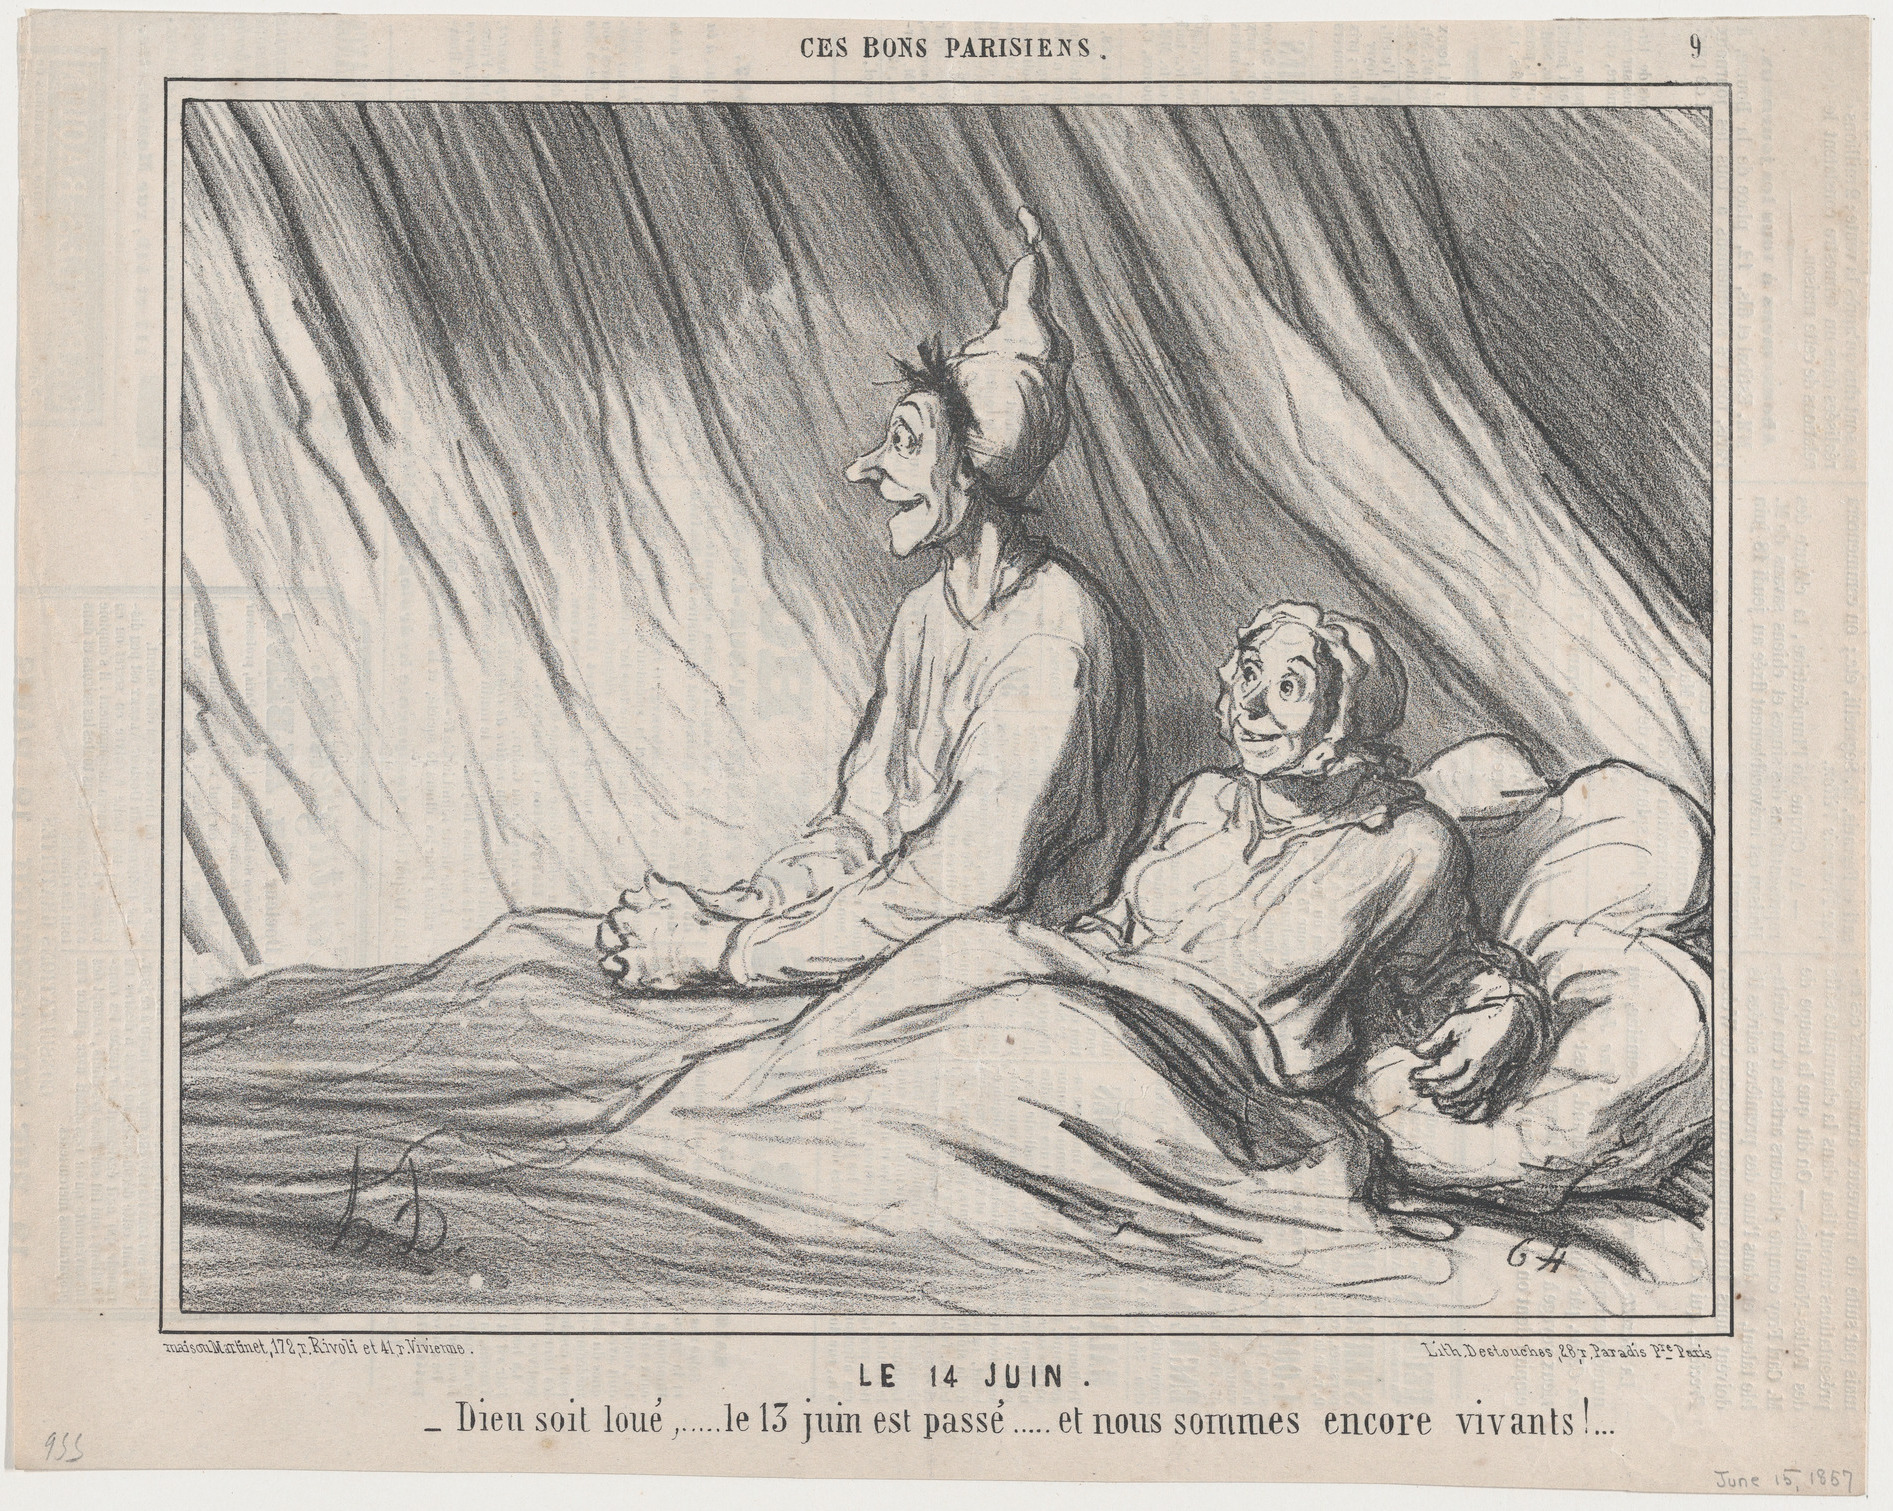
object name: print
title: Le 14 Juin, from Ces Bons Parisiens, published in Le Charivari, June 15, 1857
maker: honoré daumier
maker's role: artist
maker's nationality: french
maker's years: 1808-1879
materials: paper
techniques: lithograph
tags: satire,men,women